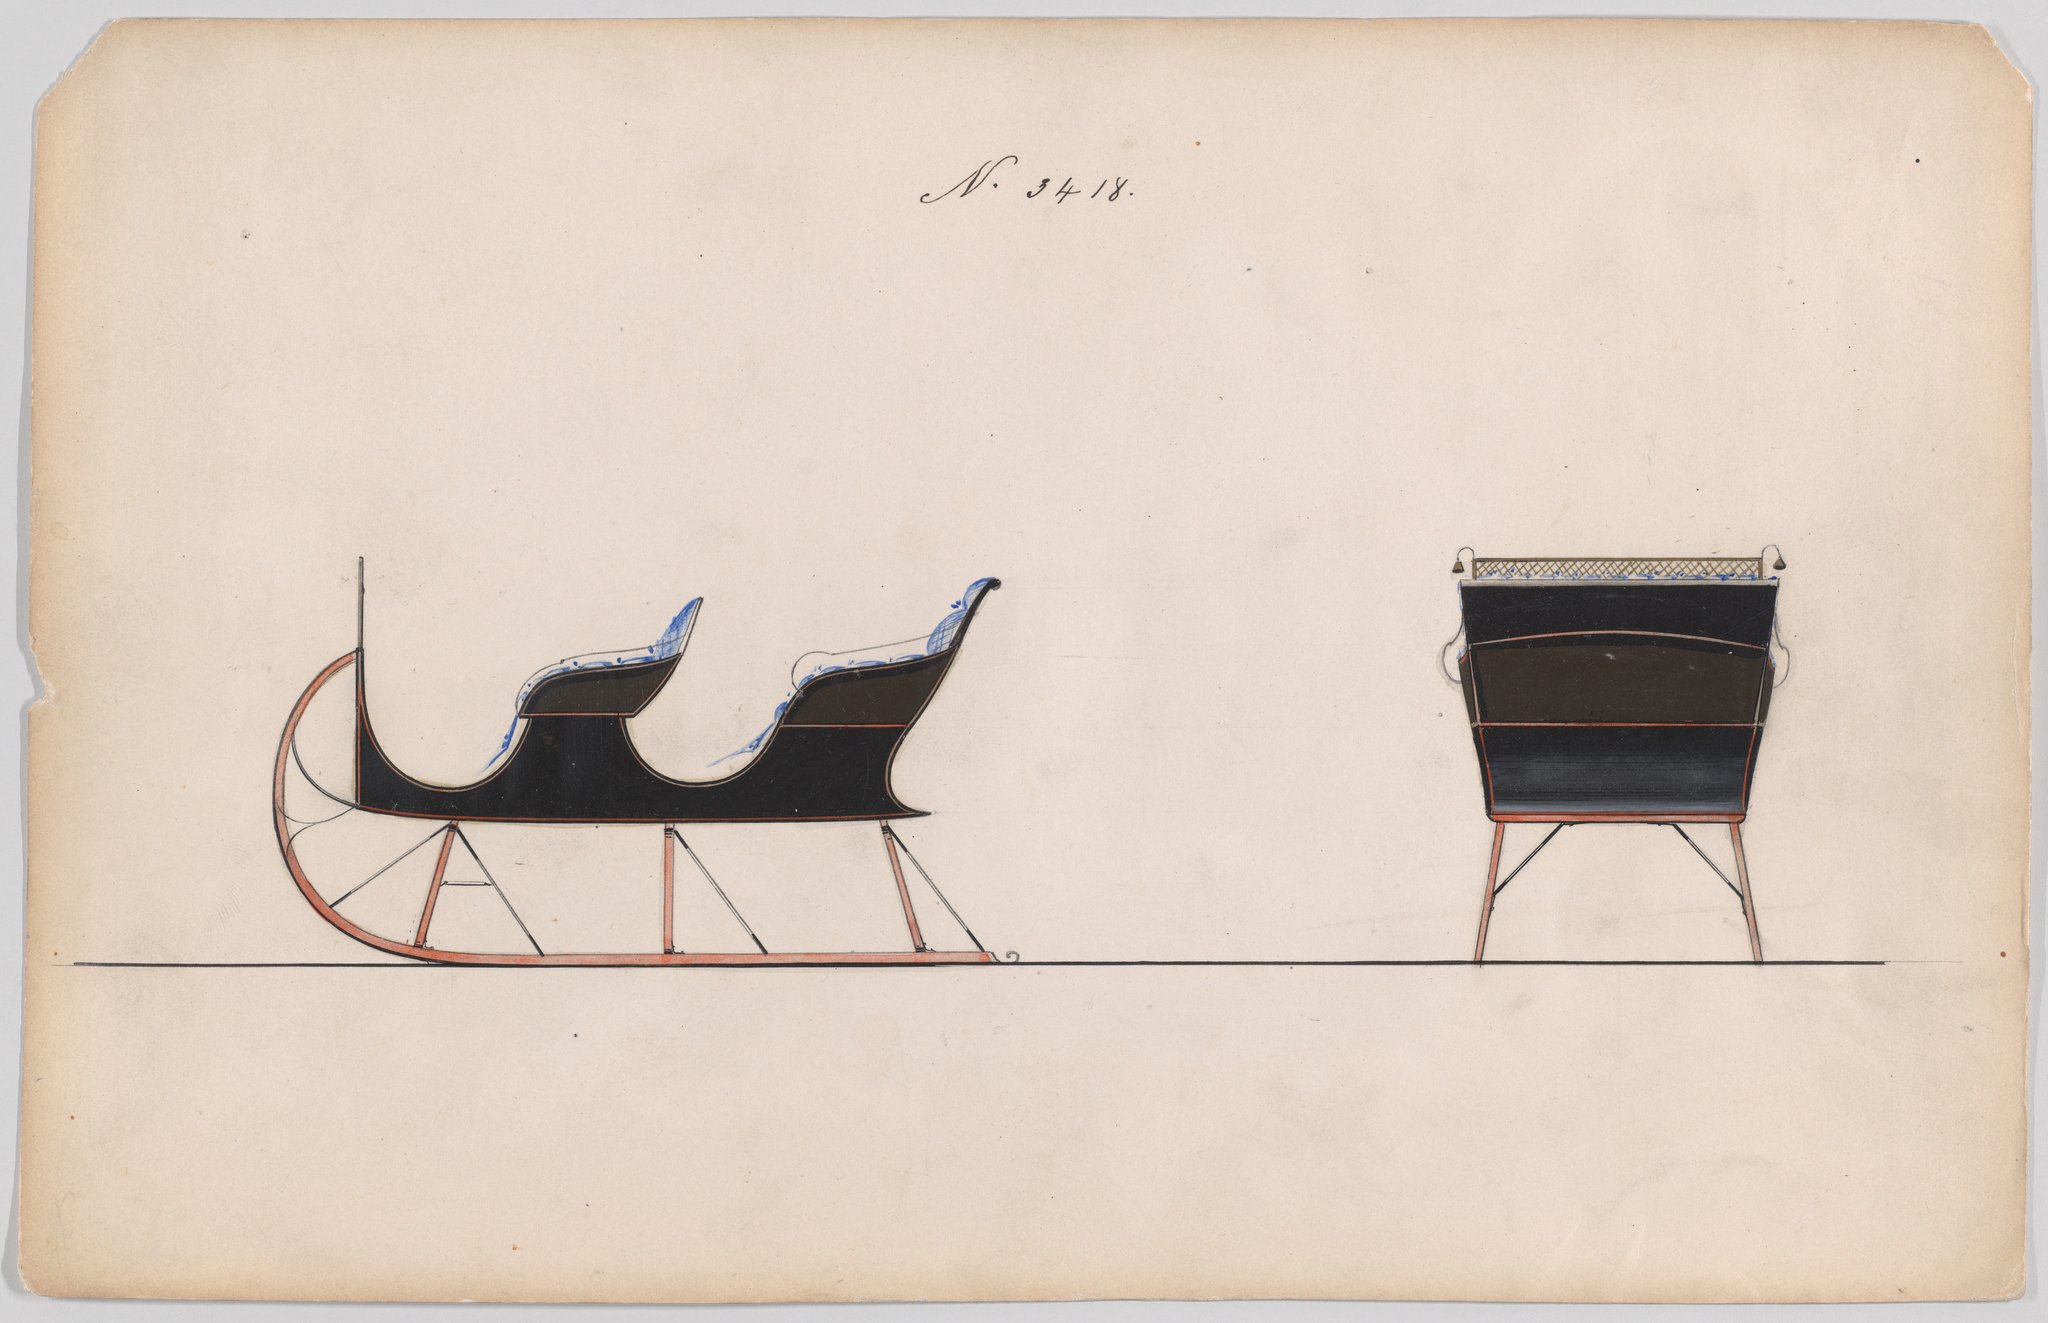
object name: drawing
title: Design for 4 Seat Sleigh, no. 3418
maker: brewster & co.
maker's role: manufacturer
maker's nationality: american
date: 1878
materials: gouache, gum arabic, ink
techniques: pen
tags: sleighs